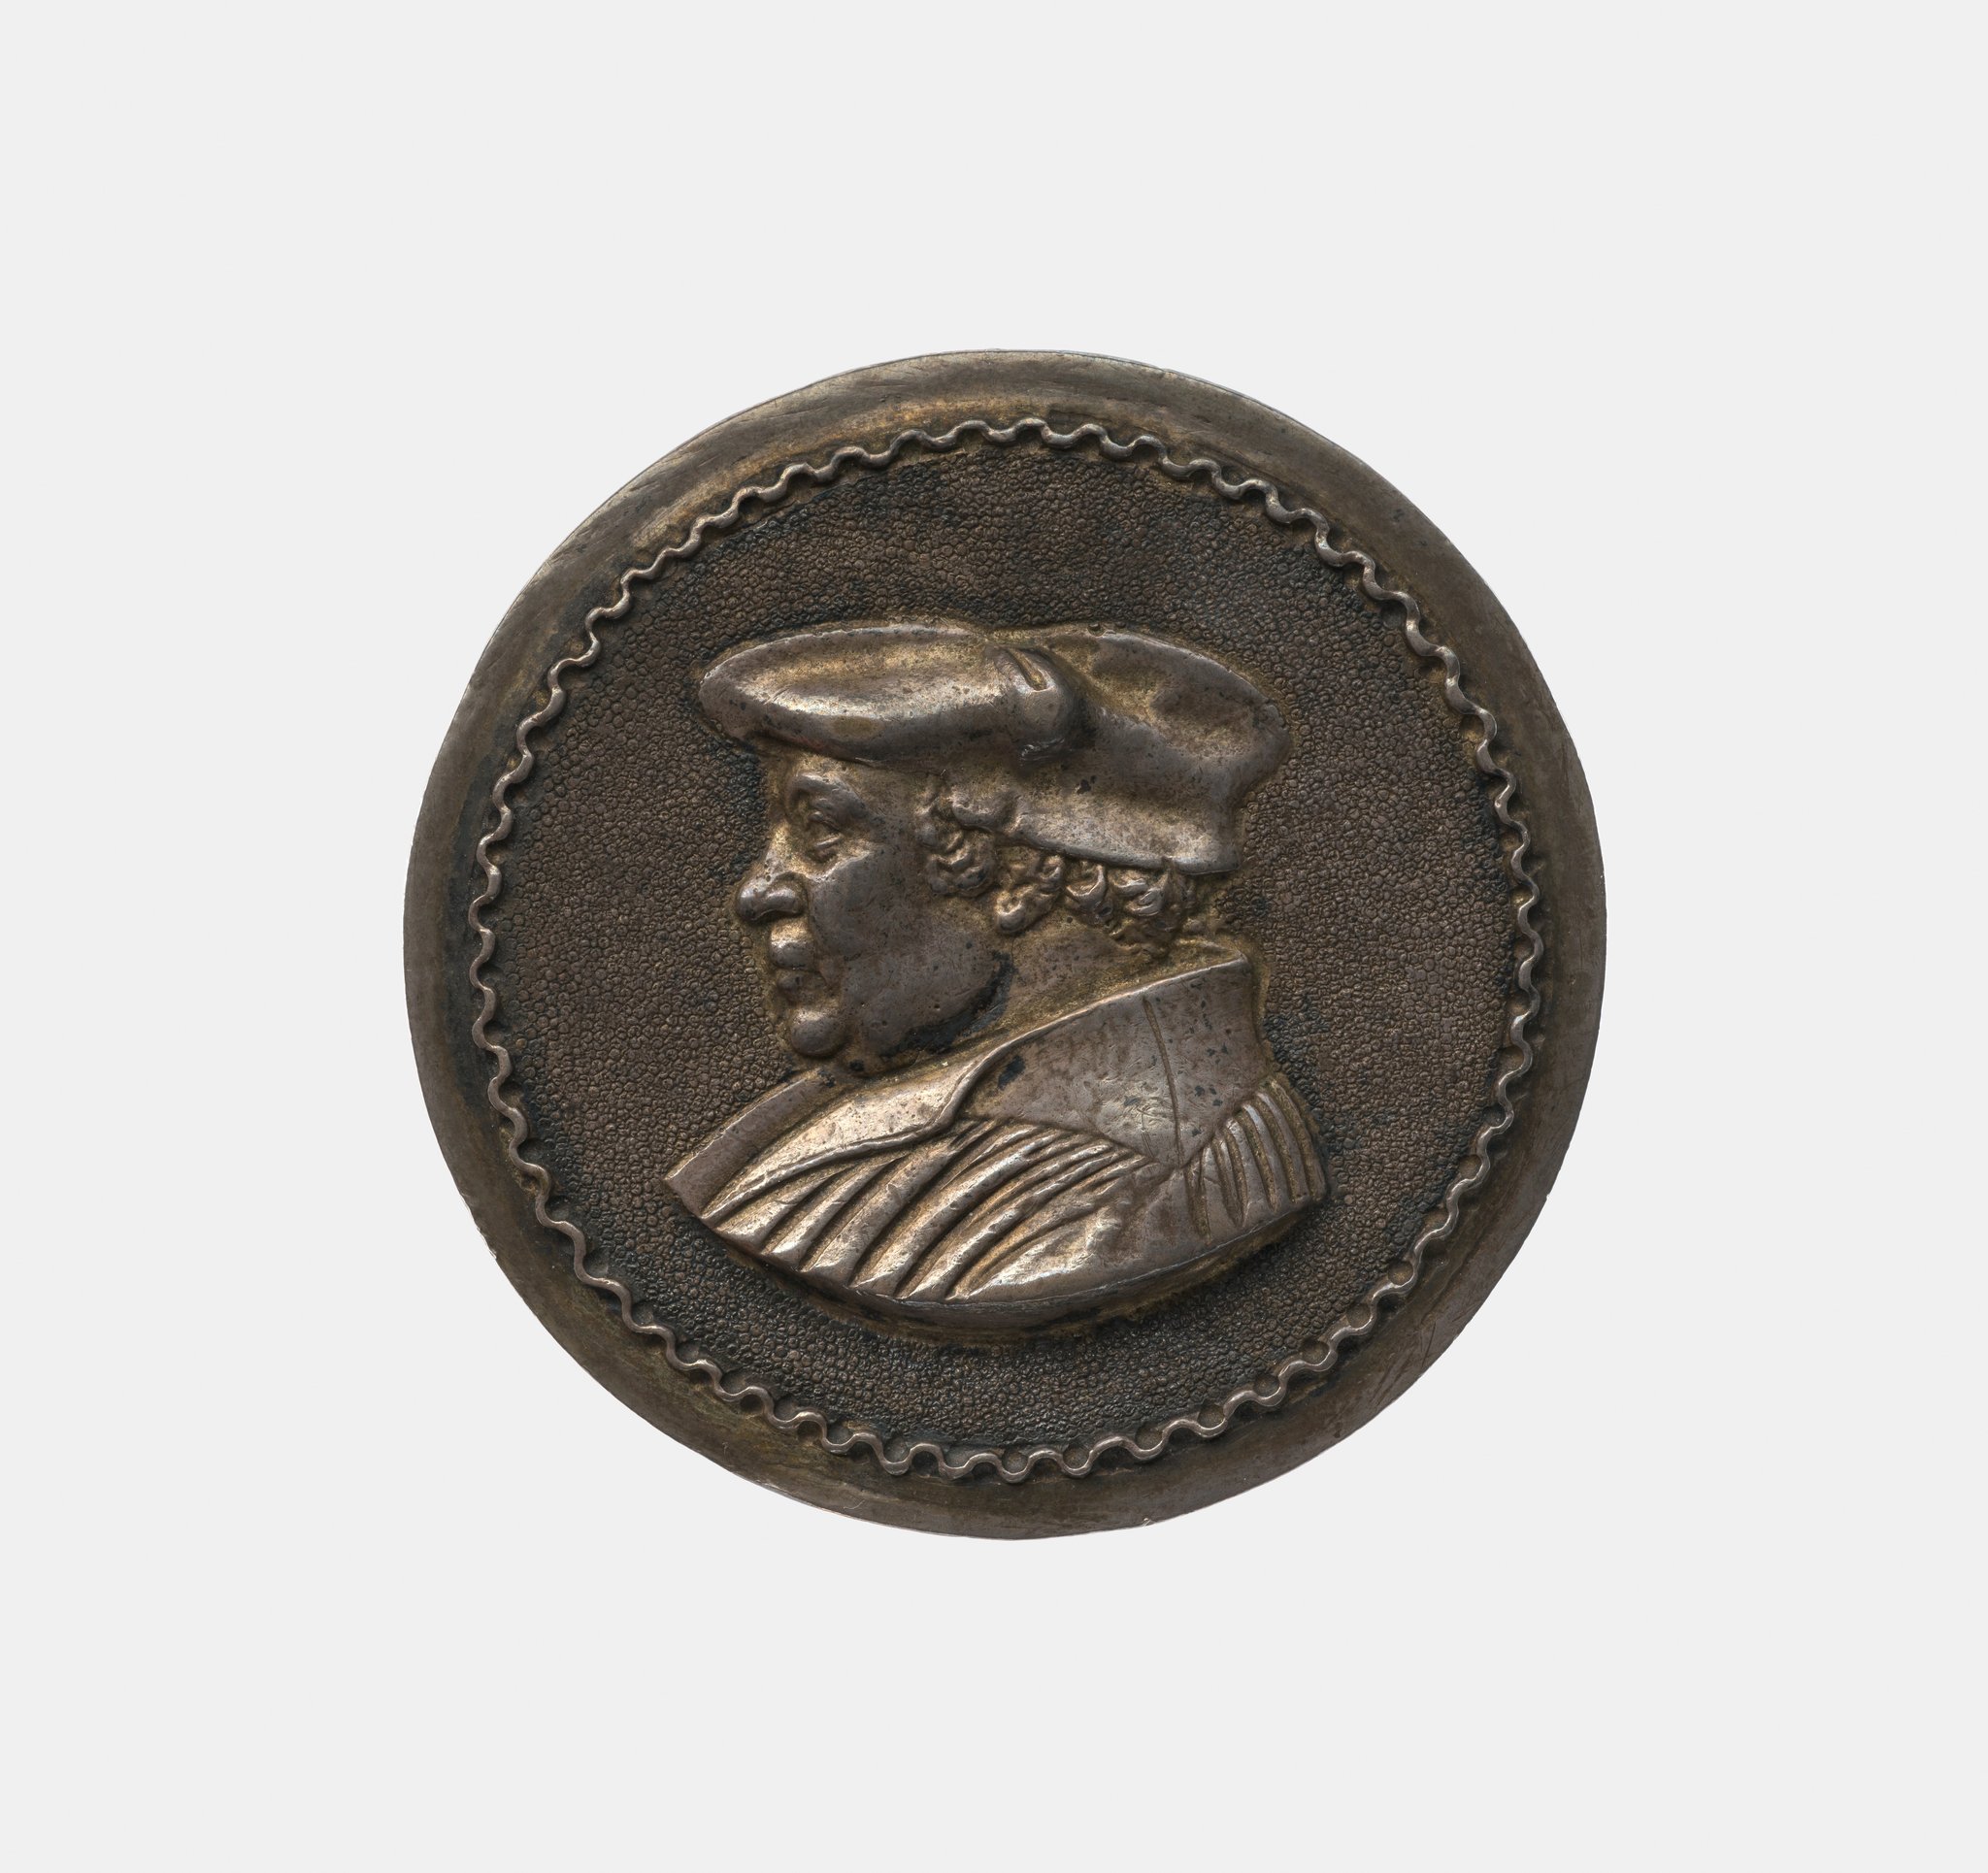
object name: medal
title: Unknown Humanist (in the past tentatively identified as Menno van Friesland 1492-1559)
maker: friedrich hagenauer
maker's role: artist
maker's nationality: german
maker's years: 1490-1546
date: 1539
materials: silver